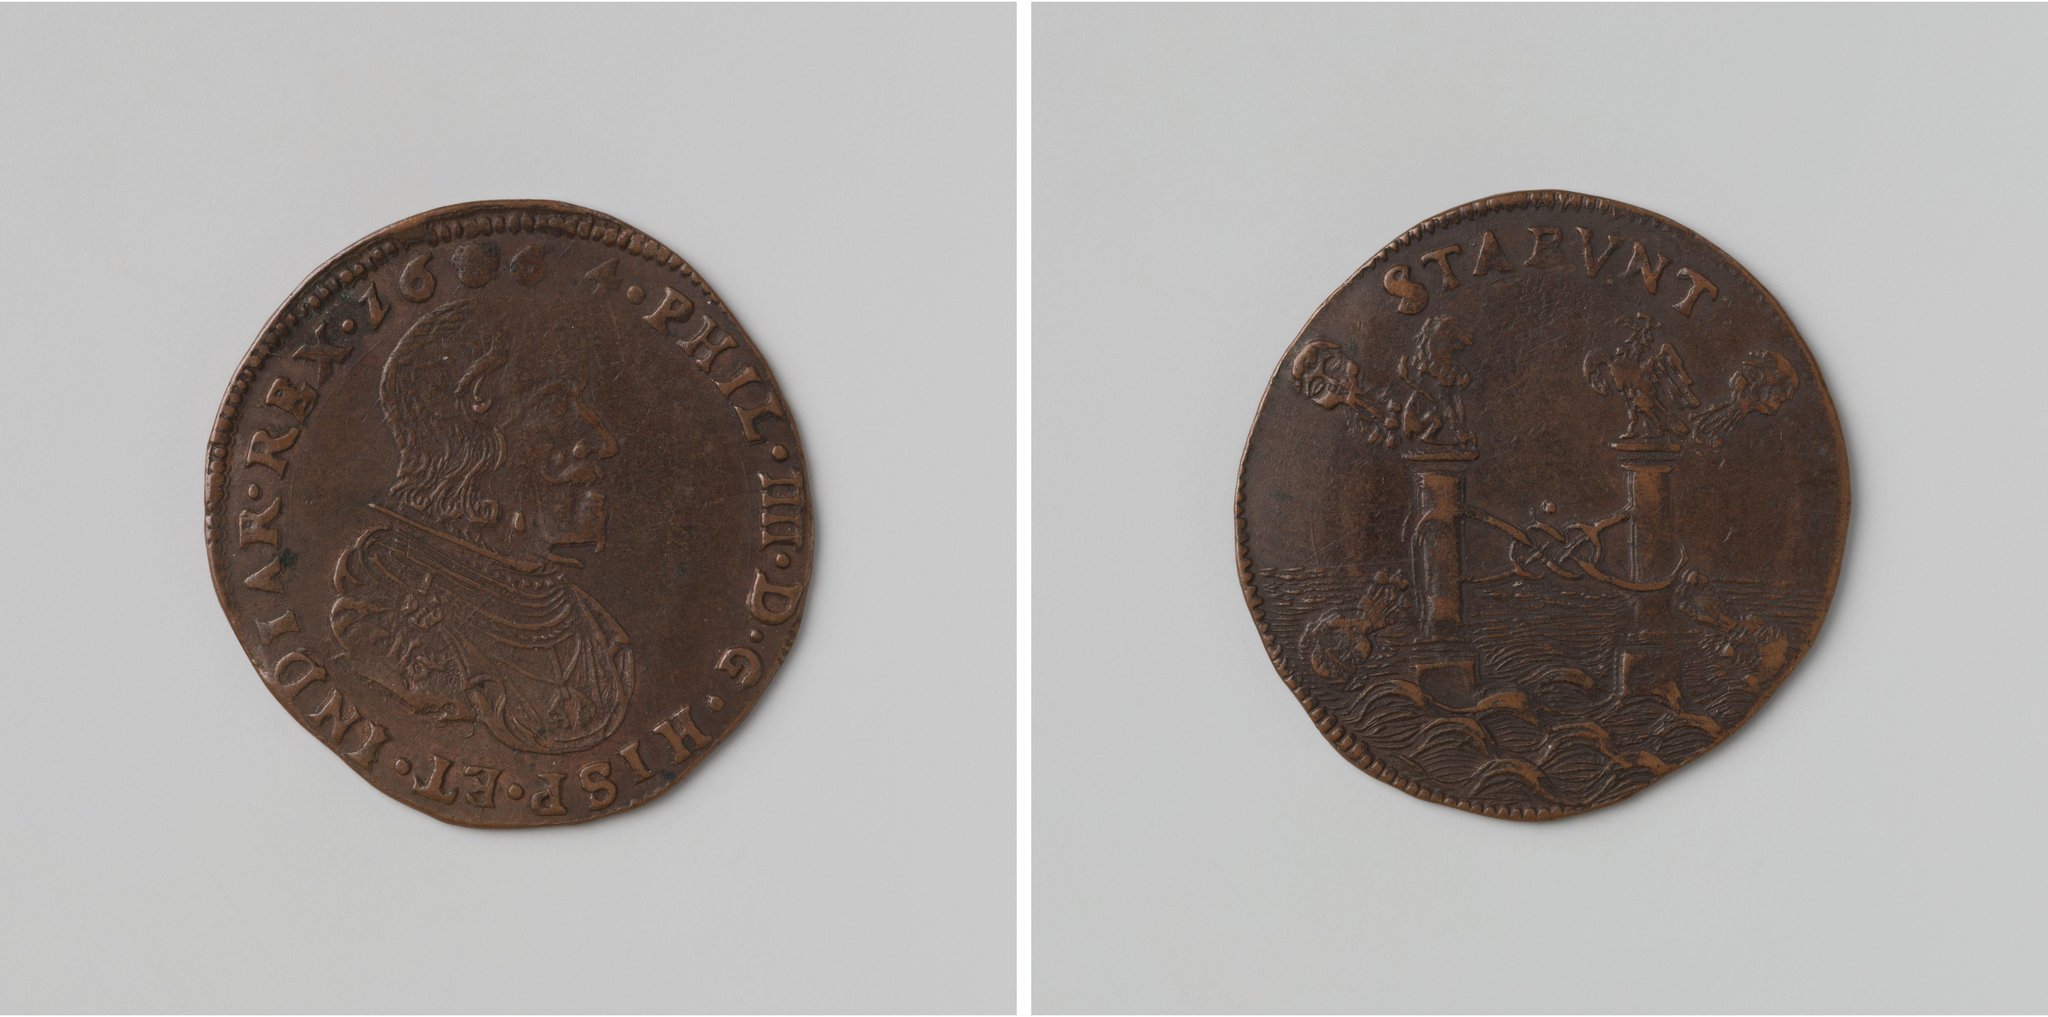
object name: jeton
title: Verbond tussen Spanje en de Duitse keizer, rekenpenning geslagen ter ere van Filips IV, koning van Spanje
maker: Anonymous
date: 1664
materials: copper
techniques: striking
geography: brussels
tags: filips iv (koning van spanje), leopold i (keizer van duitsland), germany, spain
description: Koperen penning. Voorzijde: borststuk man binnen omschrift. Keerzijde: twee met touw verbonden zuilen, waarvan linker leeuw en rechter adelaar draagt, staande in woelige zee, geteisterd door stormwinden binnen omschrift